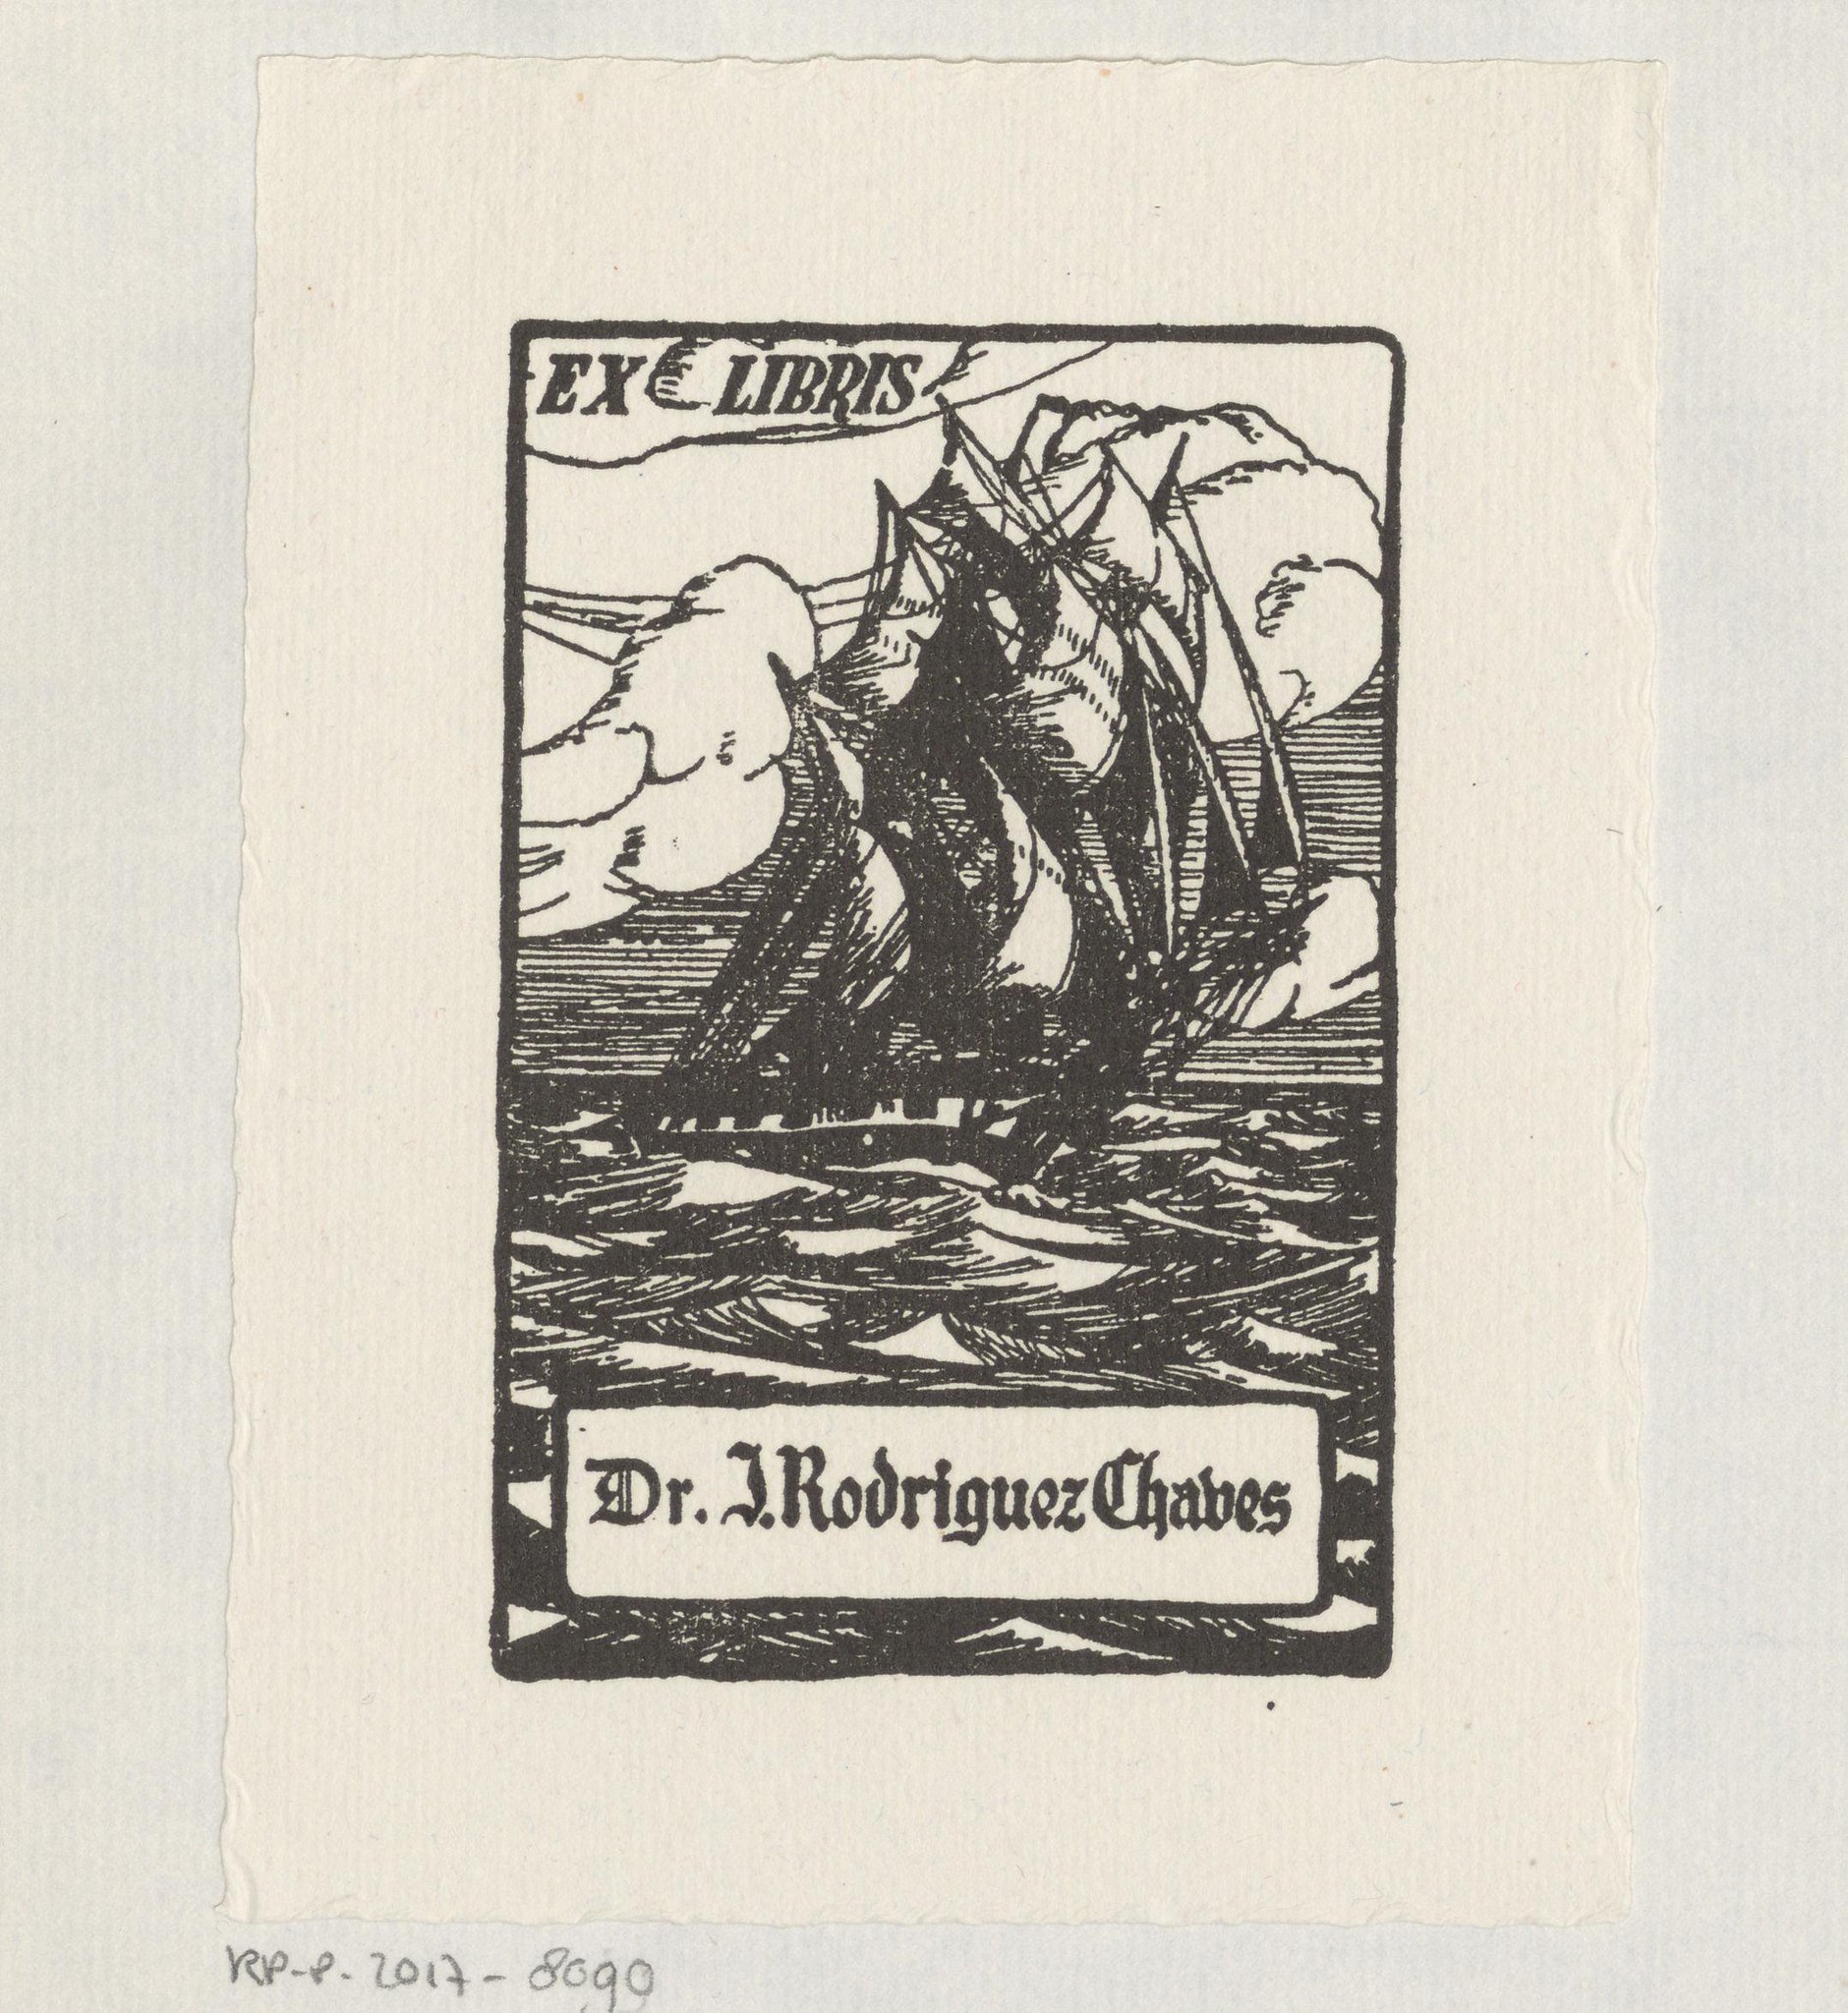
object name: bookplate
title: Ex libris van José Rodríguez Chaves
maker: Anonymous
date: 1900-1999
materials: paper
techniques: printing block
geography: spain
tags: josé rodriguez chaves, sailing-ship, sailing-boat